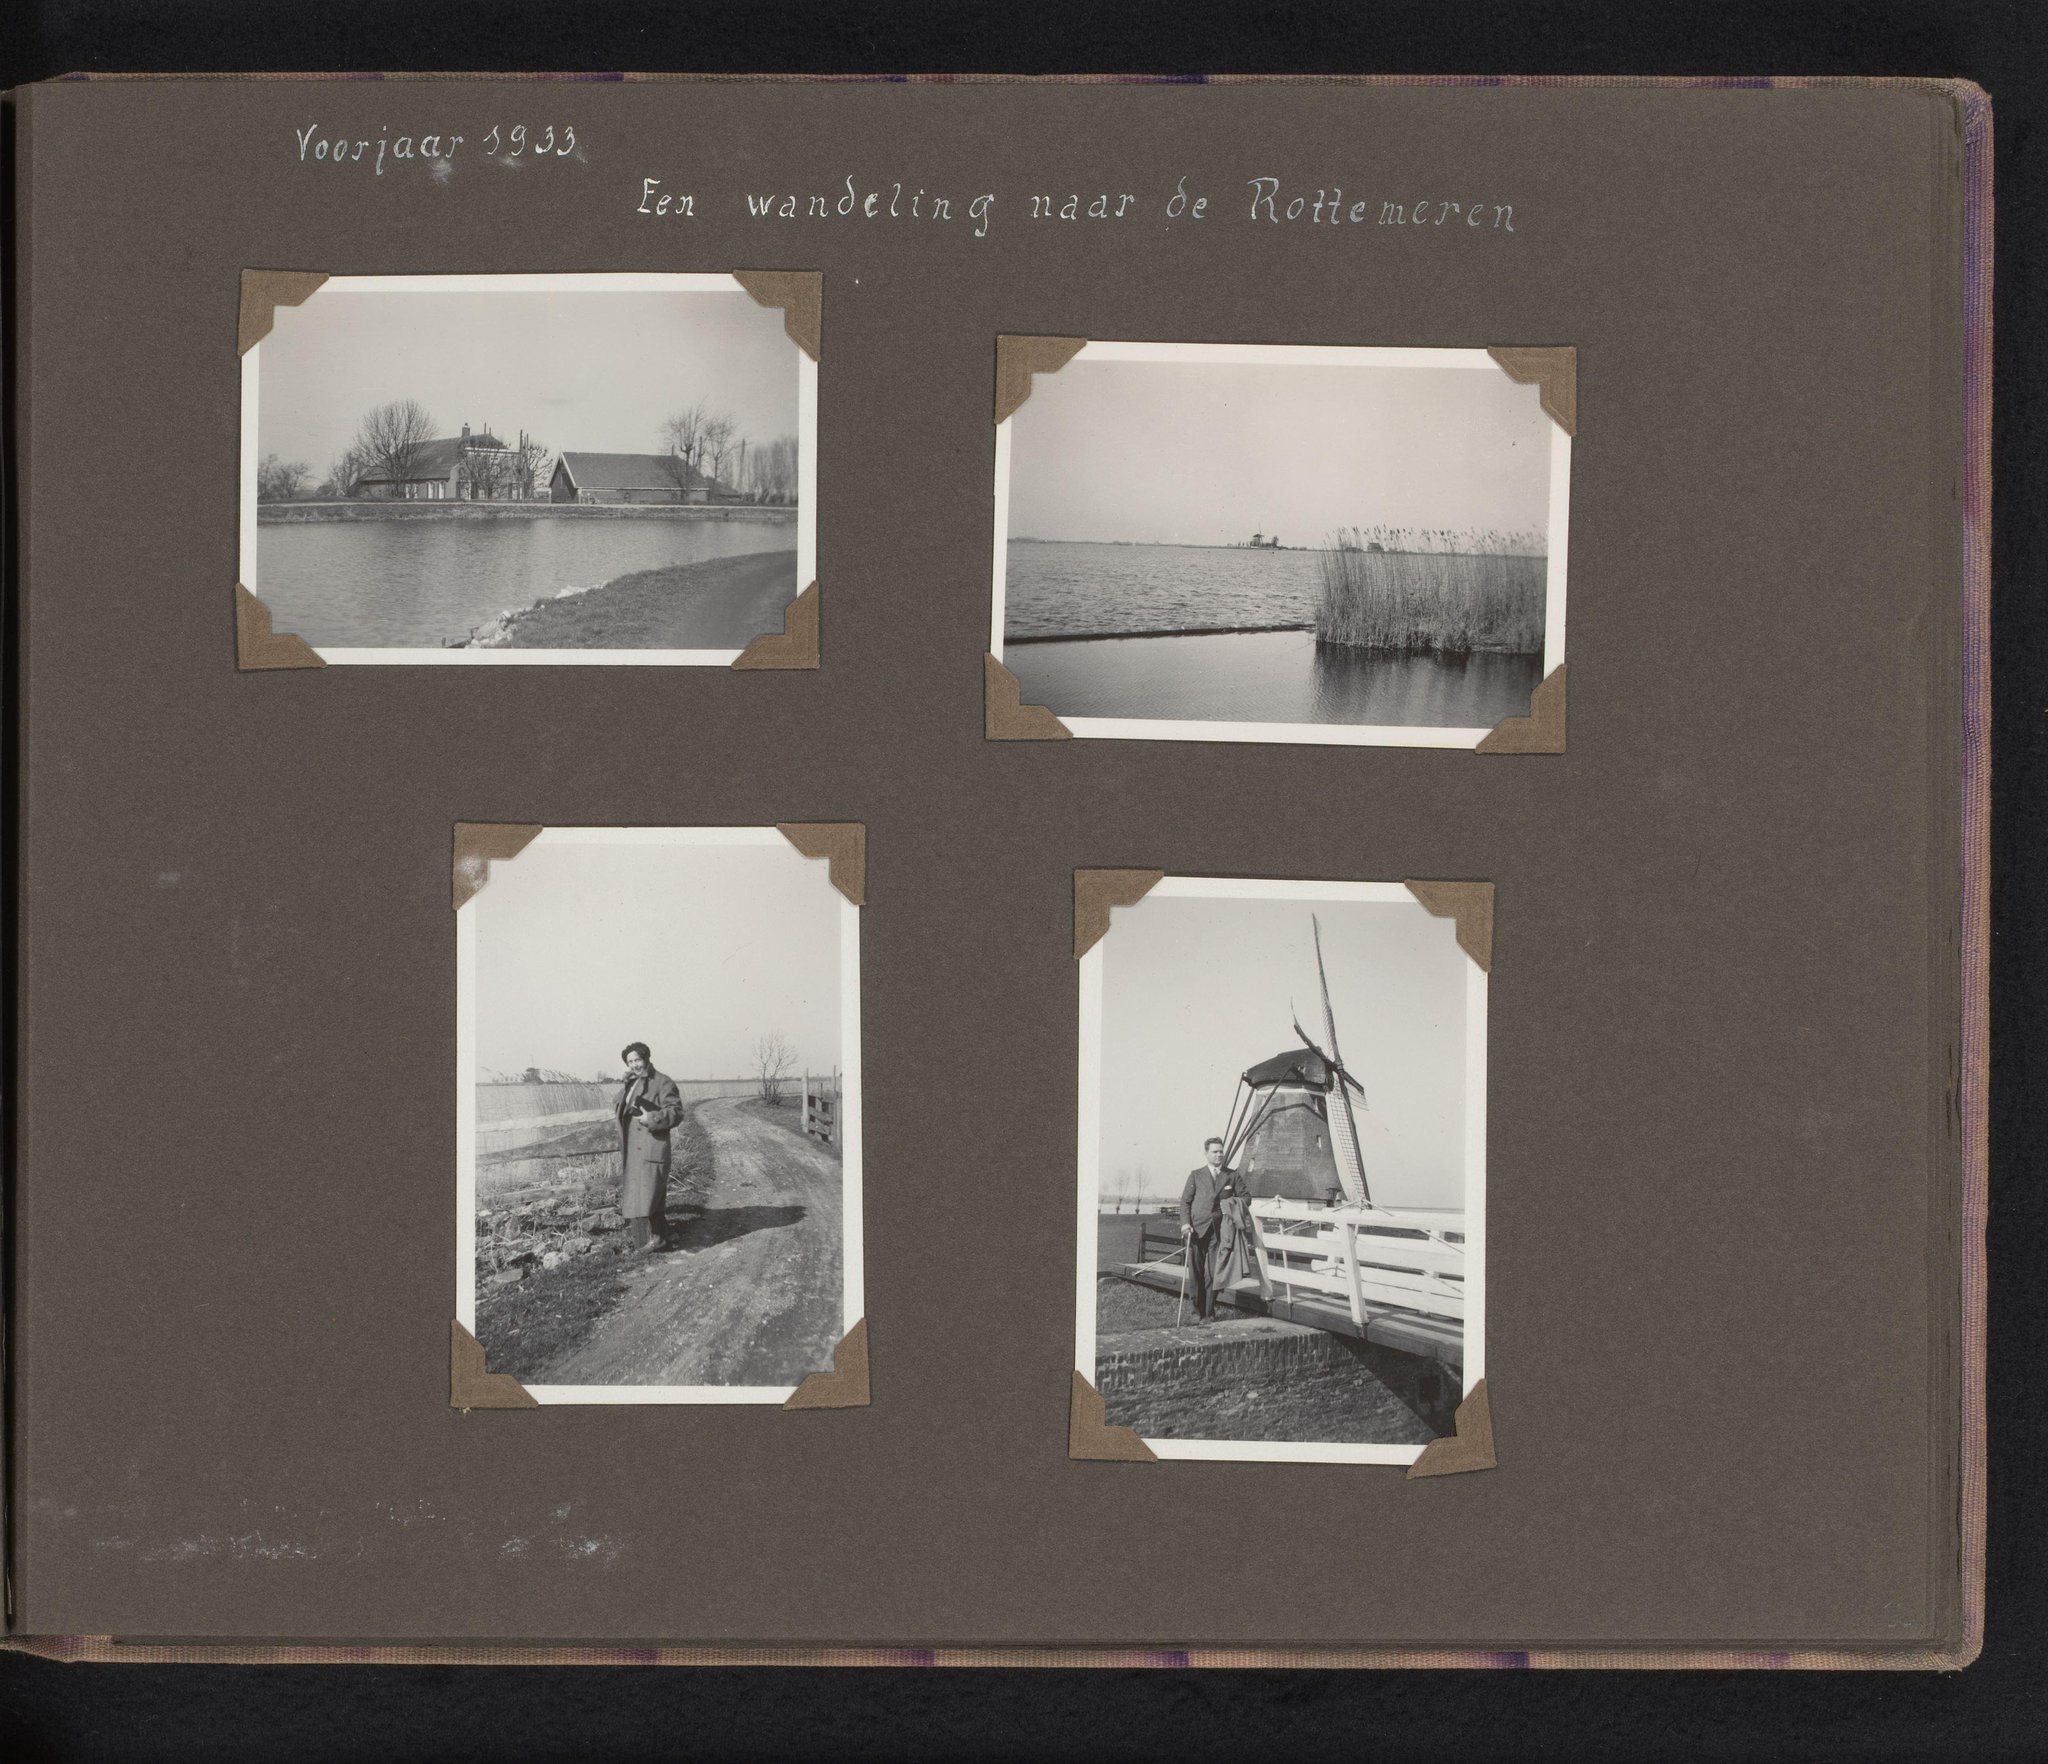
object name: photograph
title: Berti Hoppe en Herman Besselaar bij de Rottemeren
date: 1933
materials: cardboard, paper, photographic support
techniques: gelatin silver print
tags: river, windmill in landscape (+ city(-scape) with figures, staffage)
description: Vier foto's gemaakt tijdens hun bezoek aan de Rottemeren in 1933. Deze pagina maakt deel uit van een album.